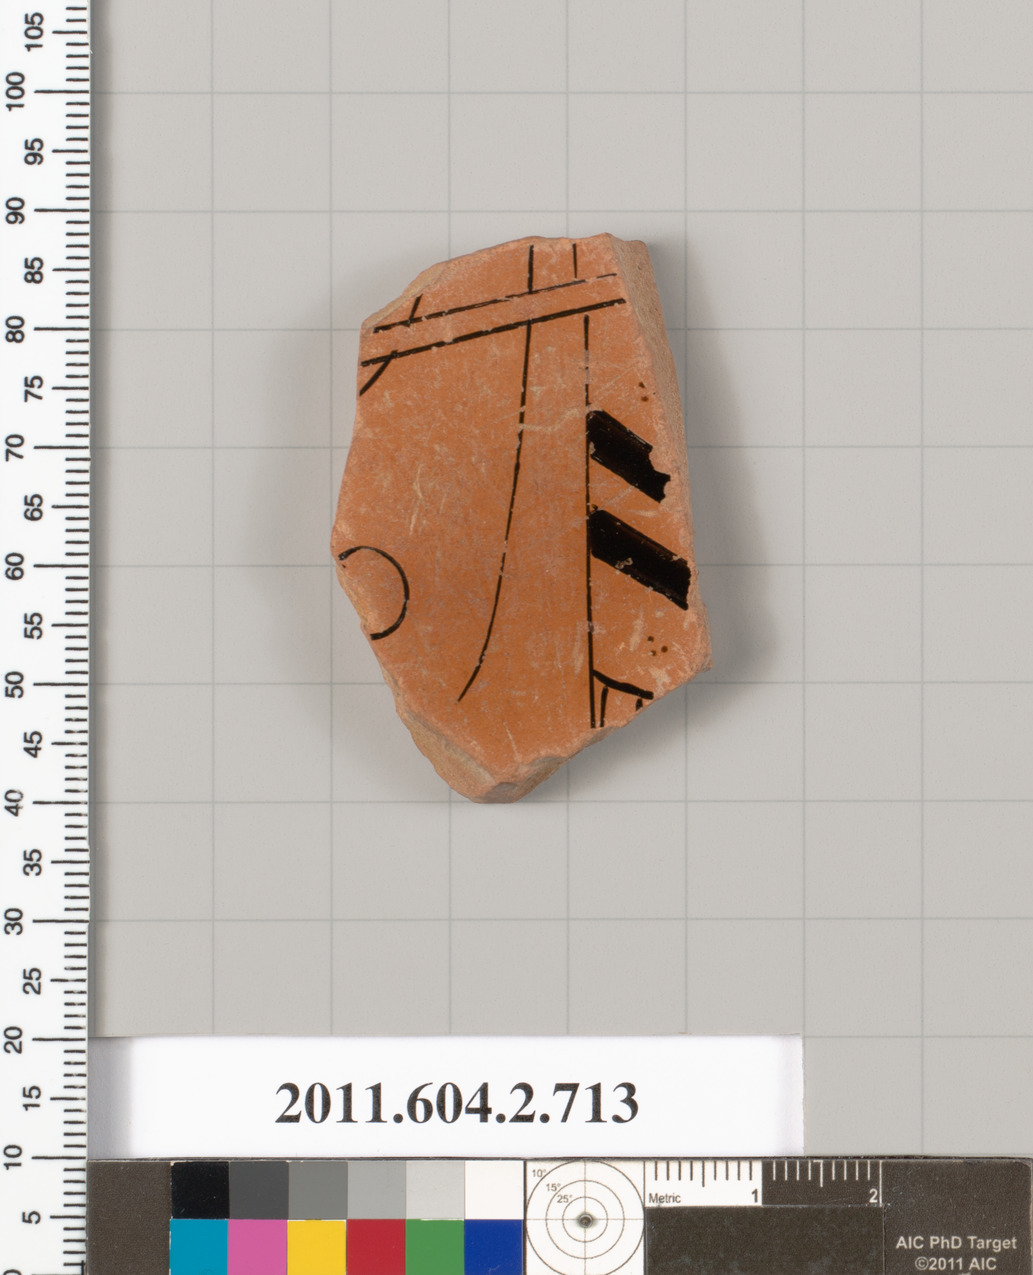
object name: calyx krater fragment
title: Terracotta fragment of a calyx-krater (bowl for mixing wine and water)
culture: greek, attic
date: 475-451 BCE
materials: terracotta